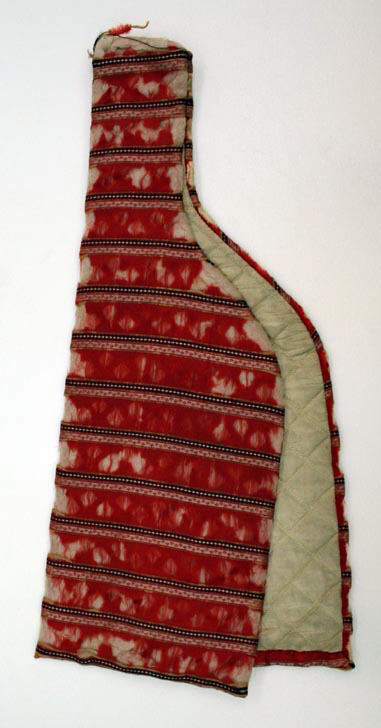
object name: chest warmer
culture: american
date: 1880-1889